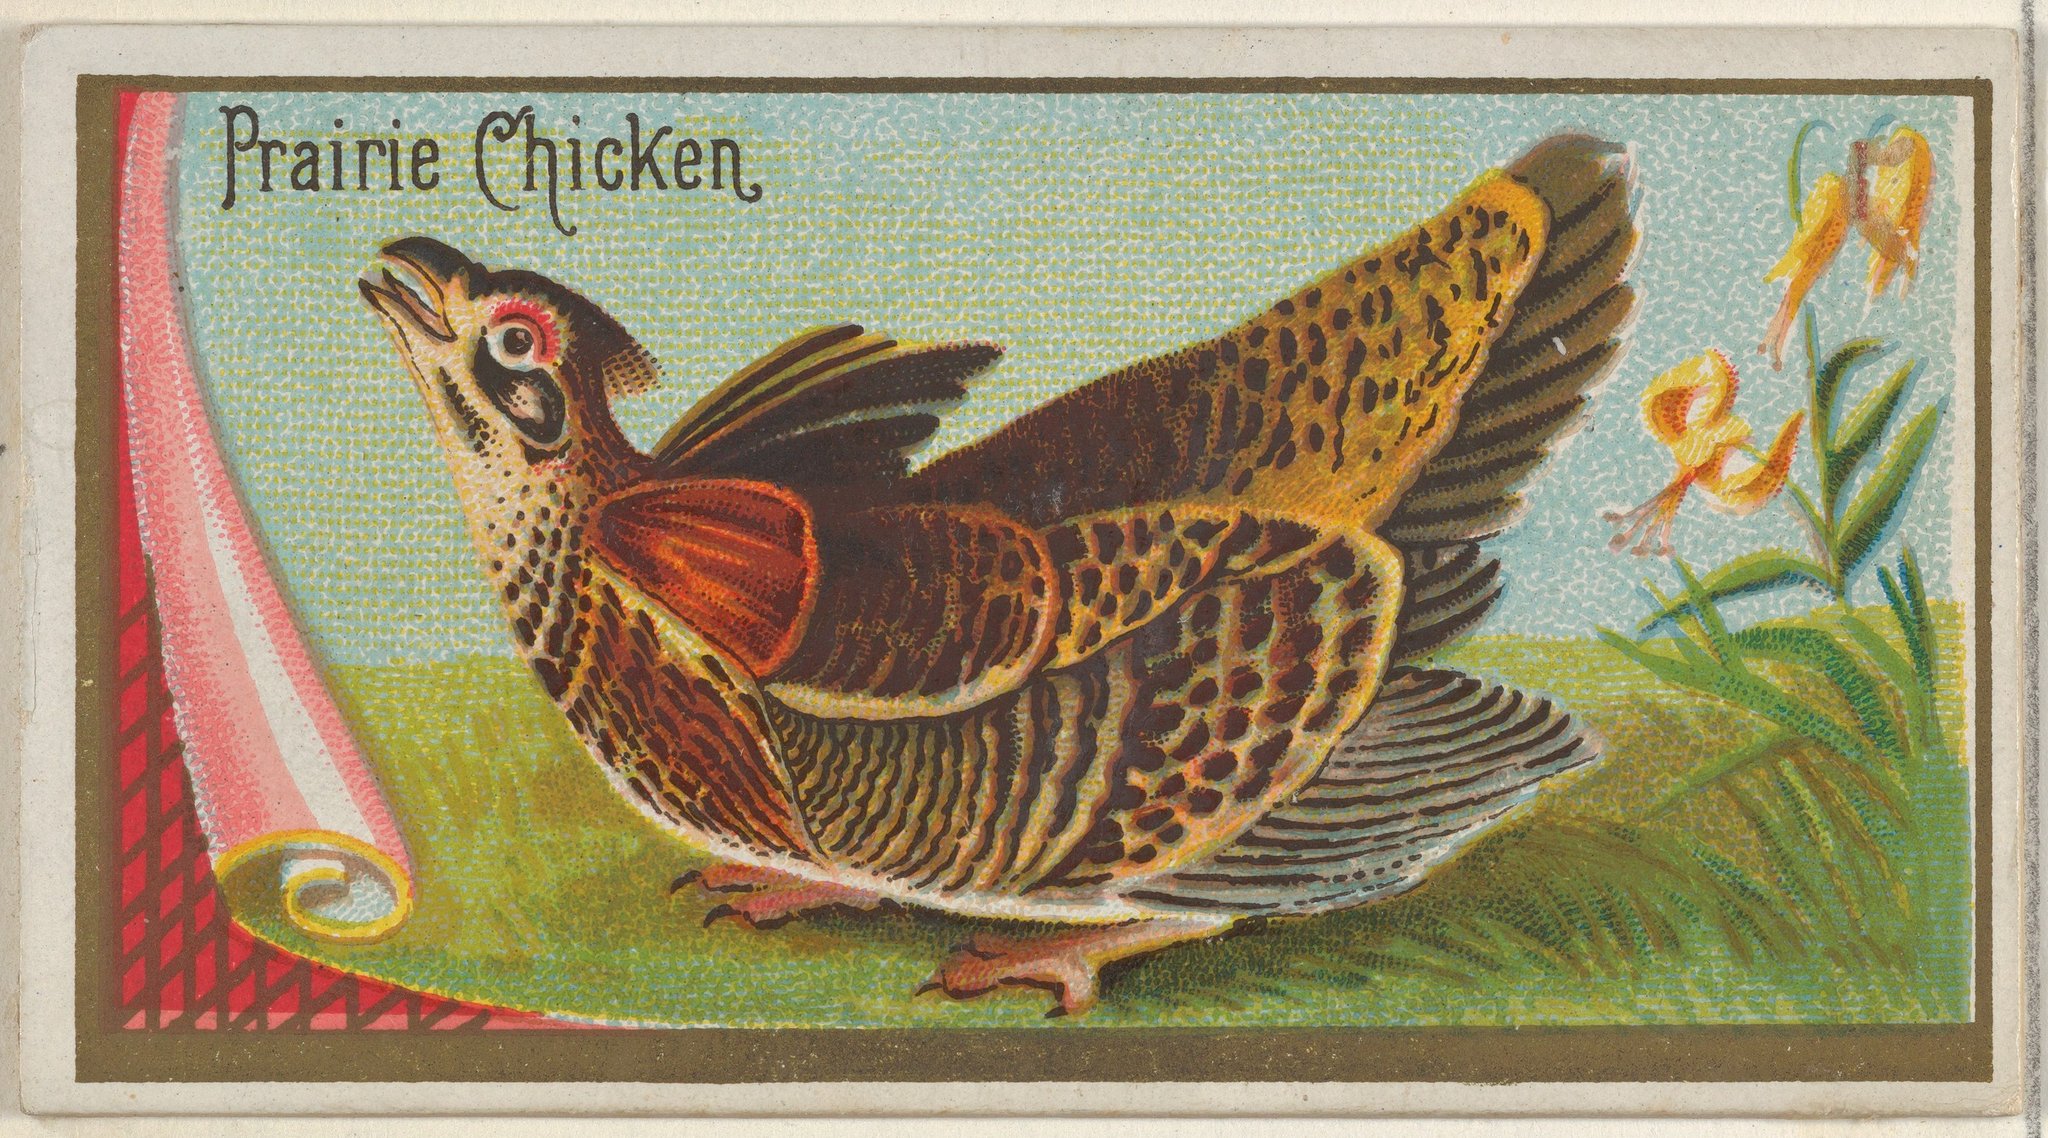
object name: print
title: Prairie Chicken, from the Game Birds series (N13) for Allen & Ginter Cigarettes Brands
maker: allen & ginter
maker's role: publisher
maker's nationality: american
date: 1889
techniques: color lithograph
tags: chickens